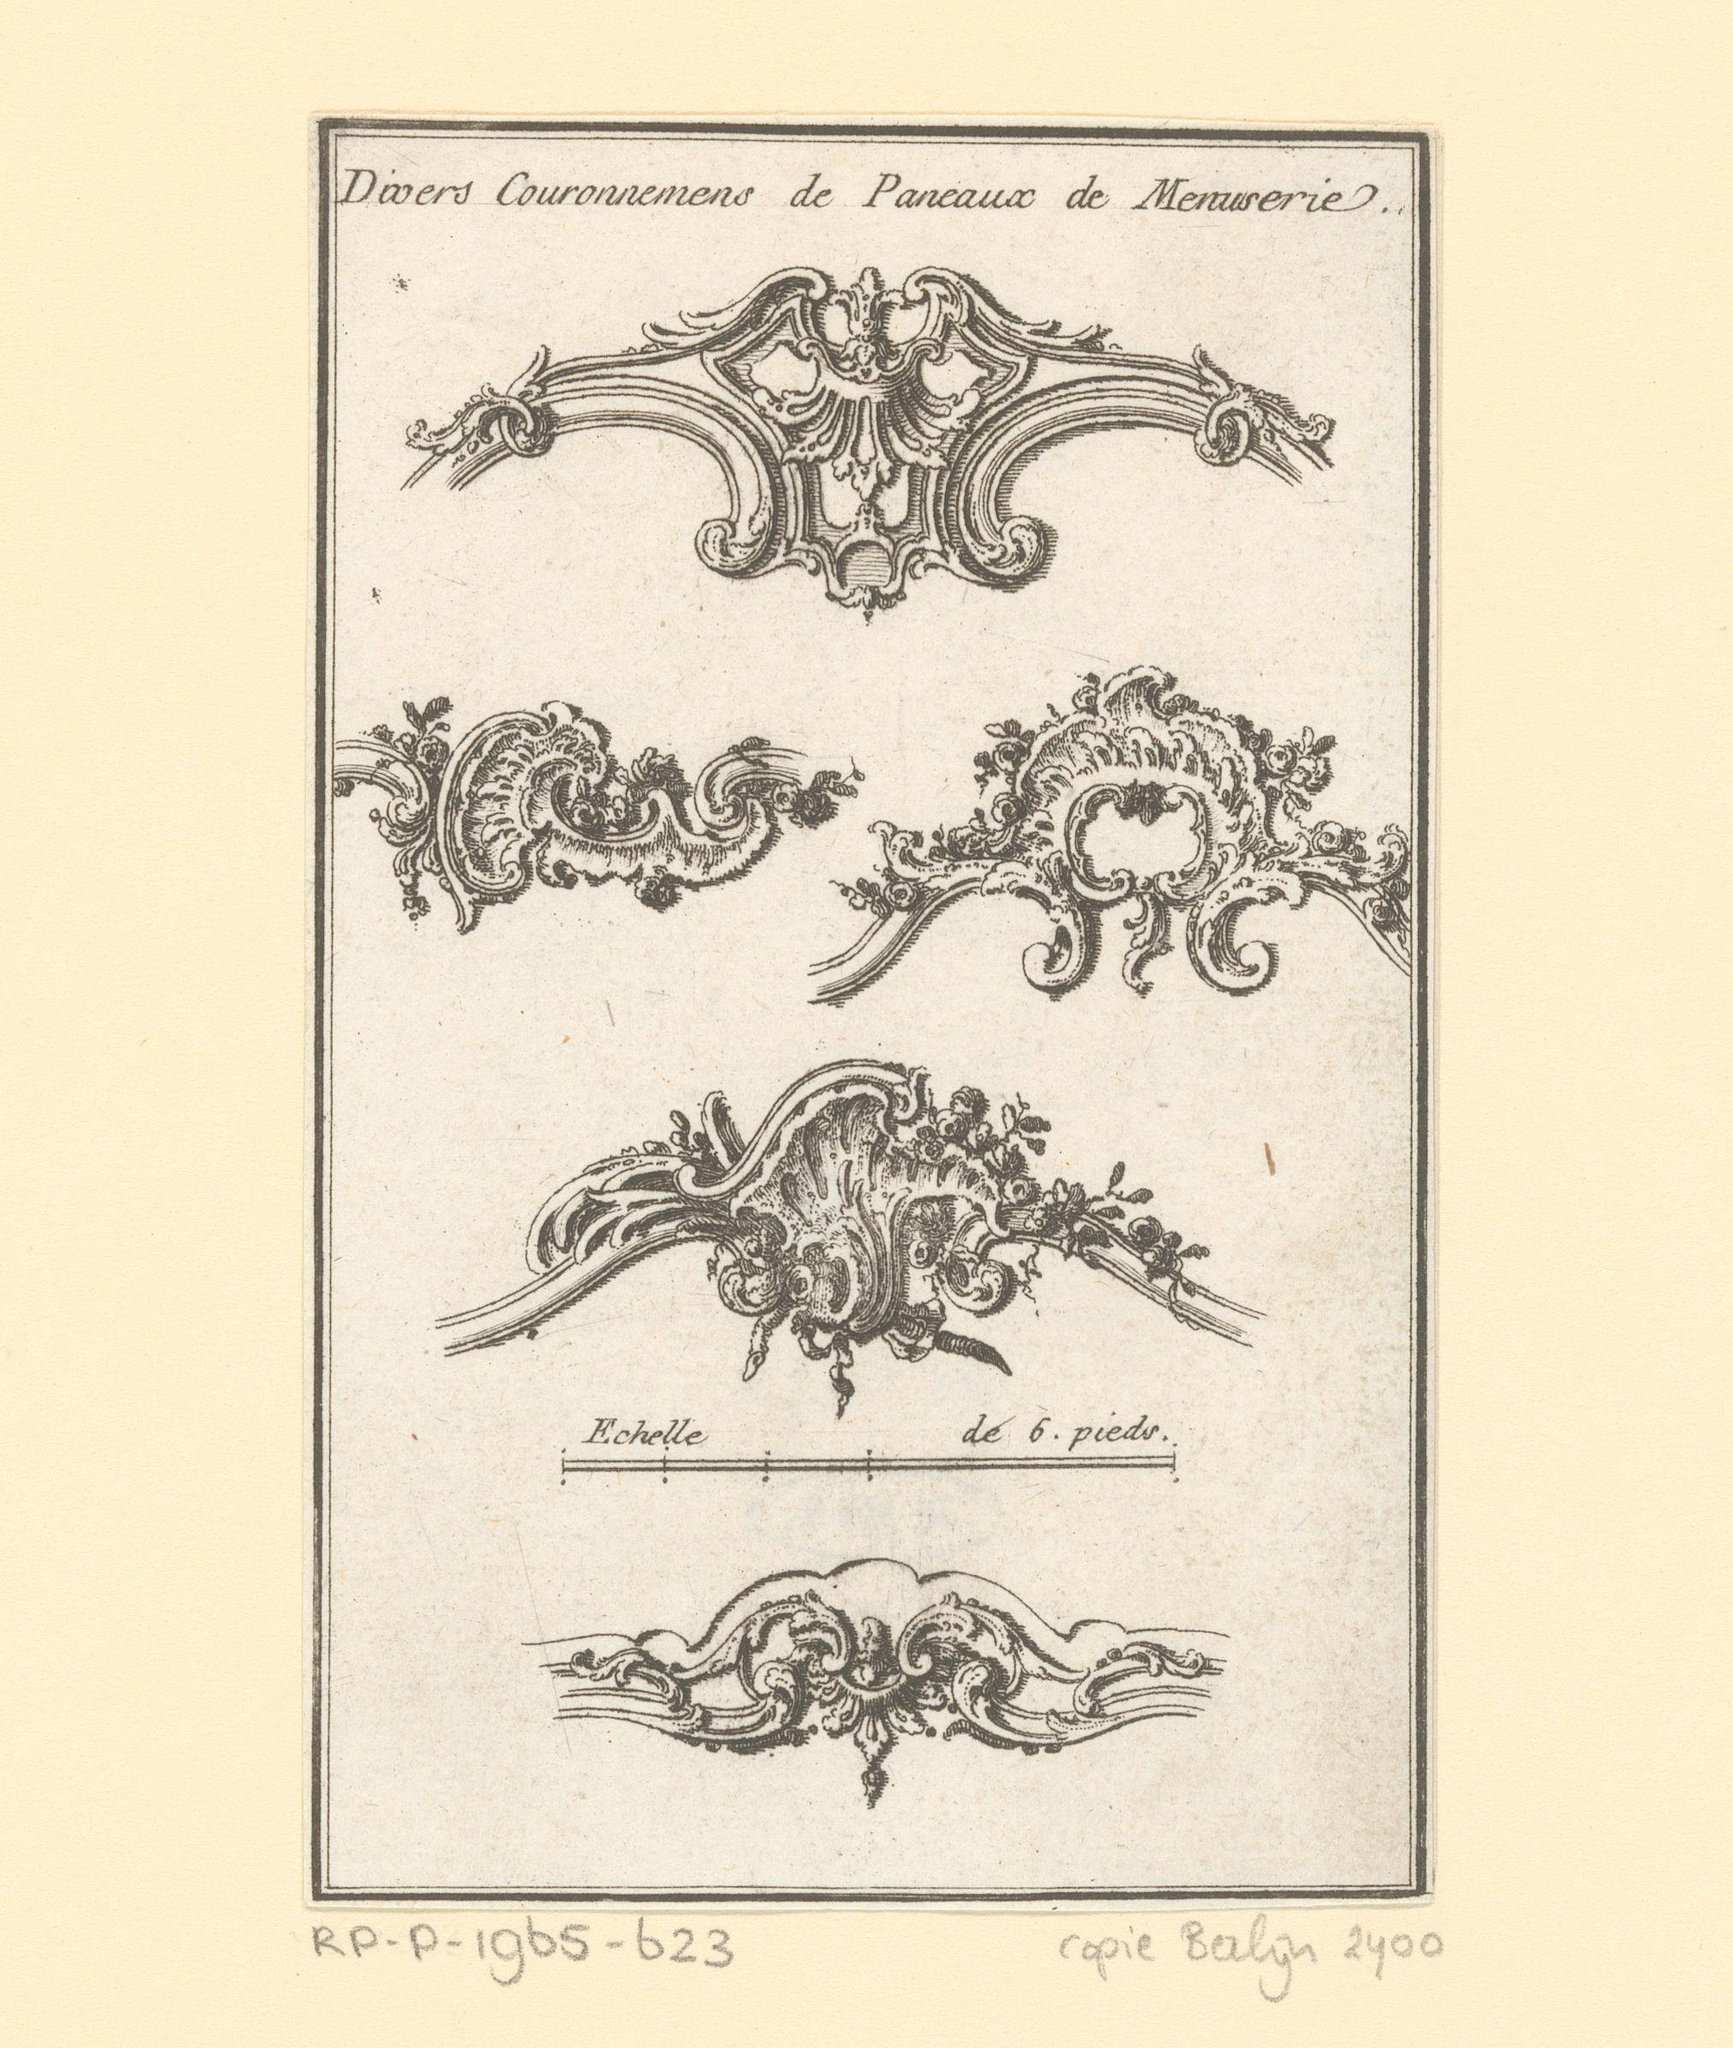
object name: print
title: Rocaille bekroningen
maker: Anonymous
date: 1738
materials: paper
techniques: etching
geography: france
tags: rocaille ornament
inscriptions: collector's mark: Lugt 2228, collector's mark: Lugt 2760